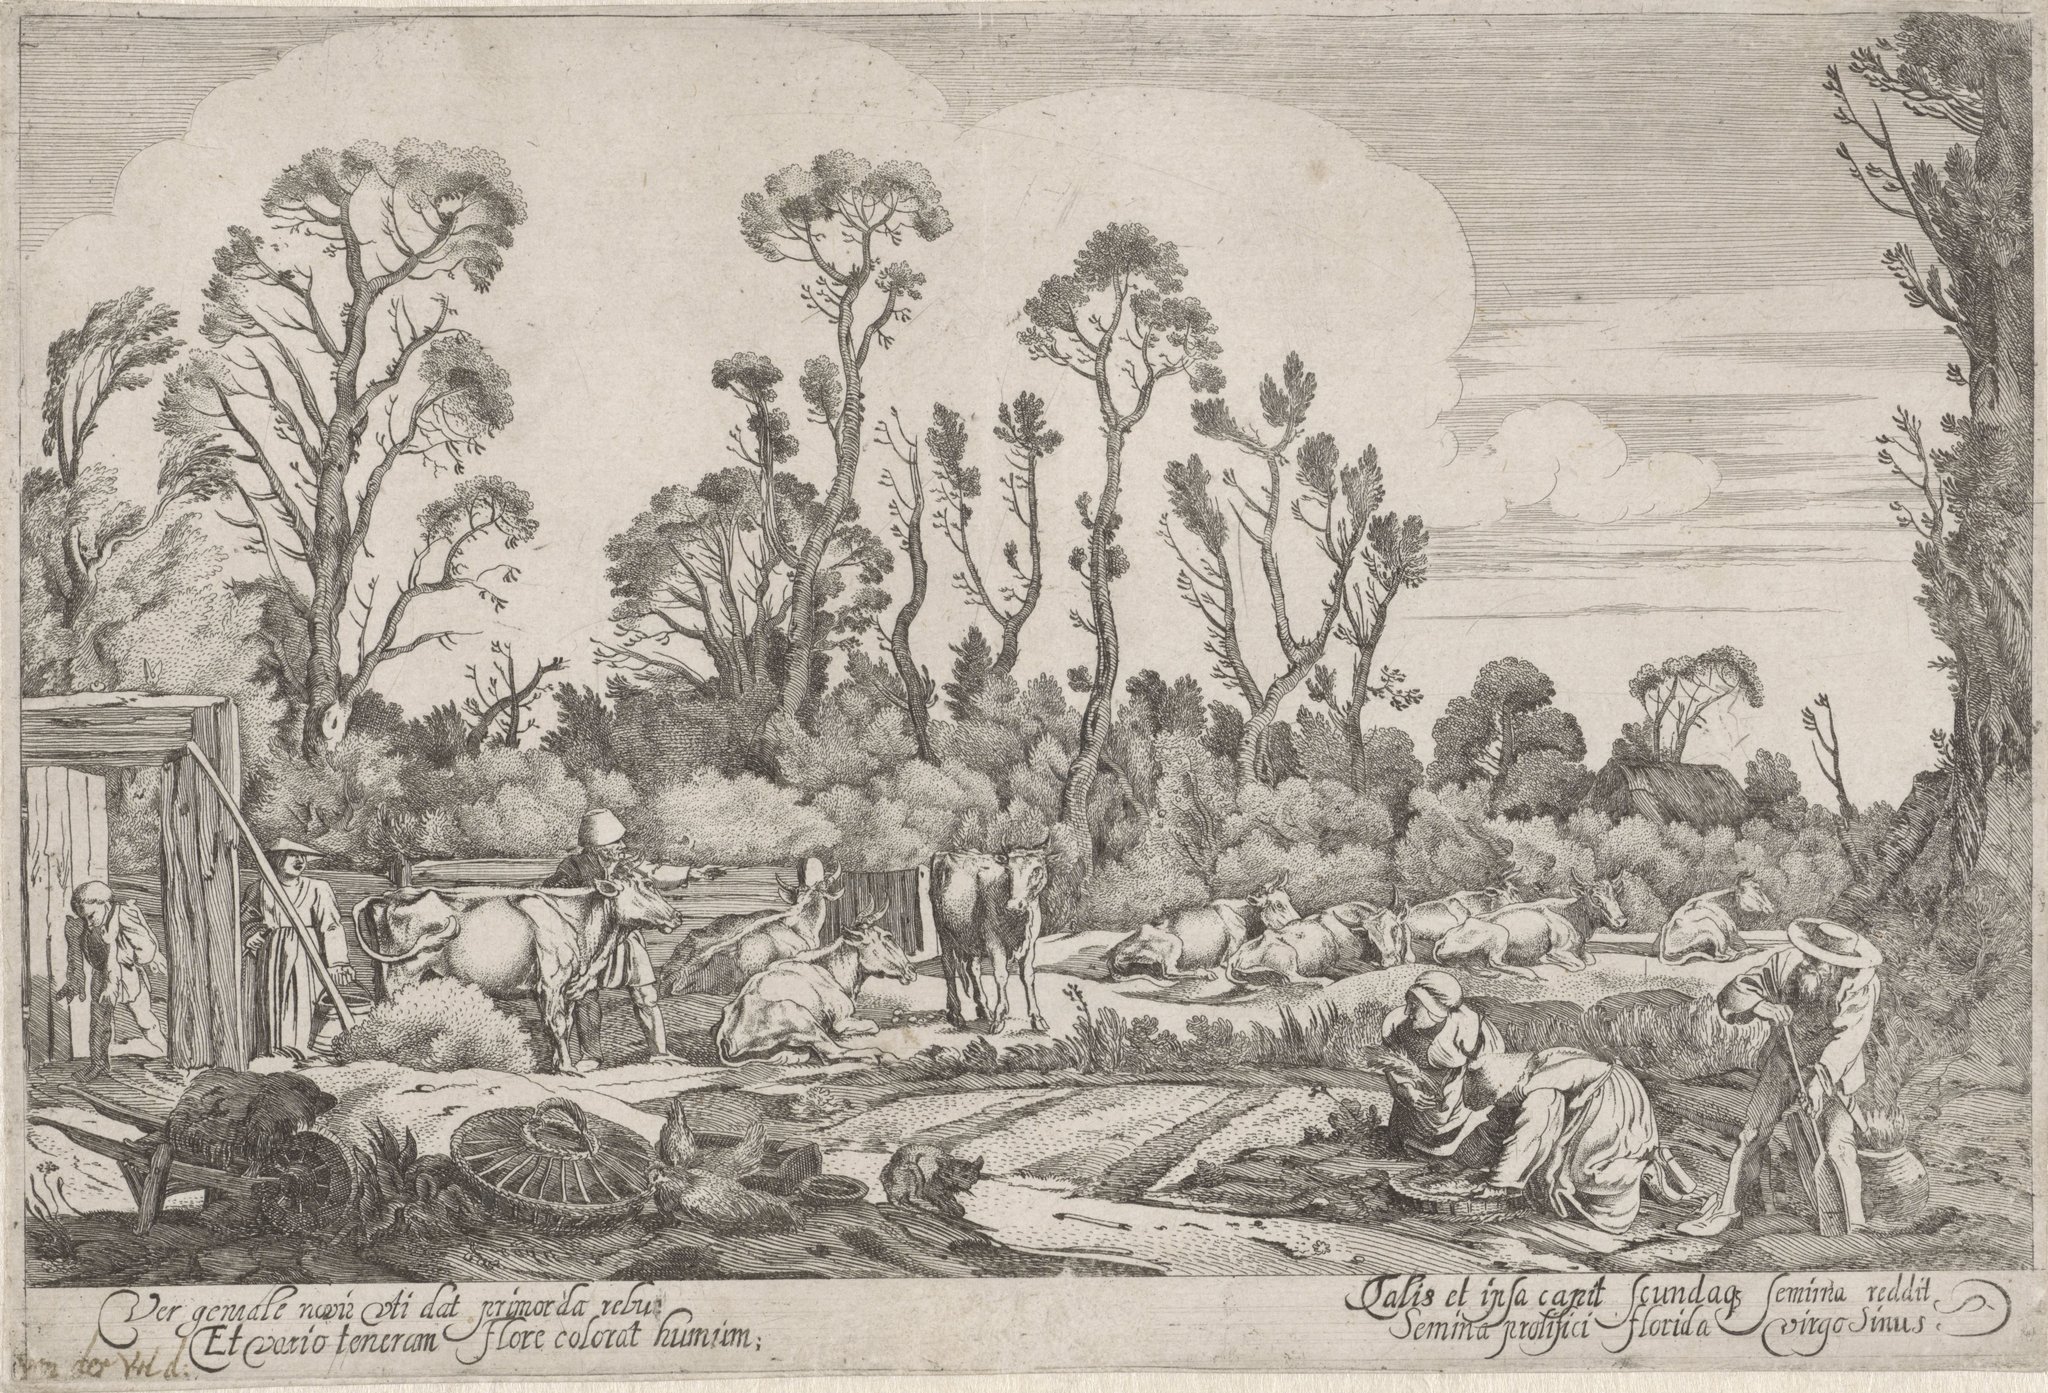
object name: print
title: Lente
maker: gillis van scheyndel (i)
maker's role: draughtsman, print maker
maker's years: 1595-1660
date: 1622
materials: paper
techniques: etching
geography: netherlands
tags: cow, spring landscape; landscape symbolizing spring (the four seasons of the year)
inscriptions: collector's mark: Lugt 2228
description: Gezicht op een lente landschap met landlieden en koeien. Rechts schept een man met een schop de aarde om terwijl de twee vrouwen naast hem onkruid wieden. Links loopt een jongen met konijnen over de schouders de deur uit, van een door een planken schutting afgesloten terrein.